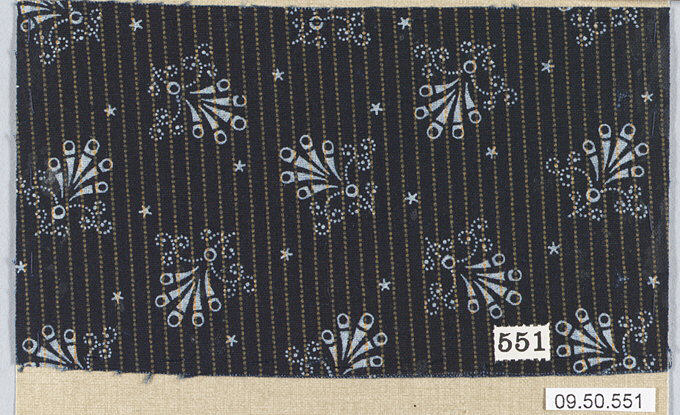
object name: piece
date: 1801-1900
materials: cotton